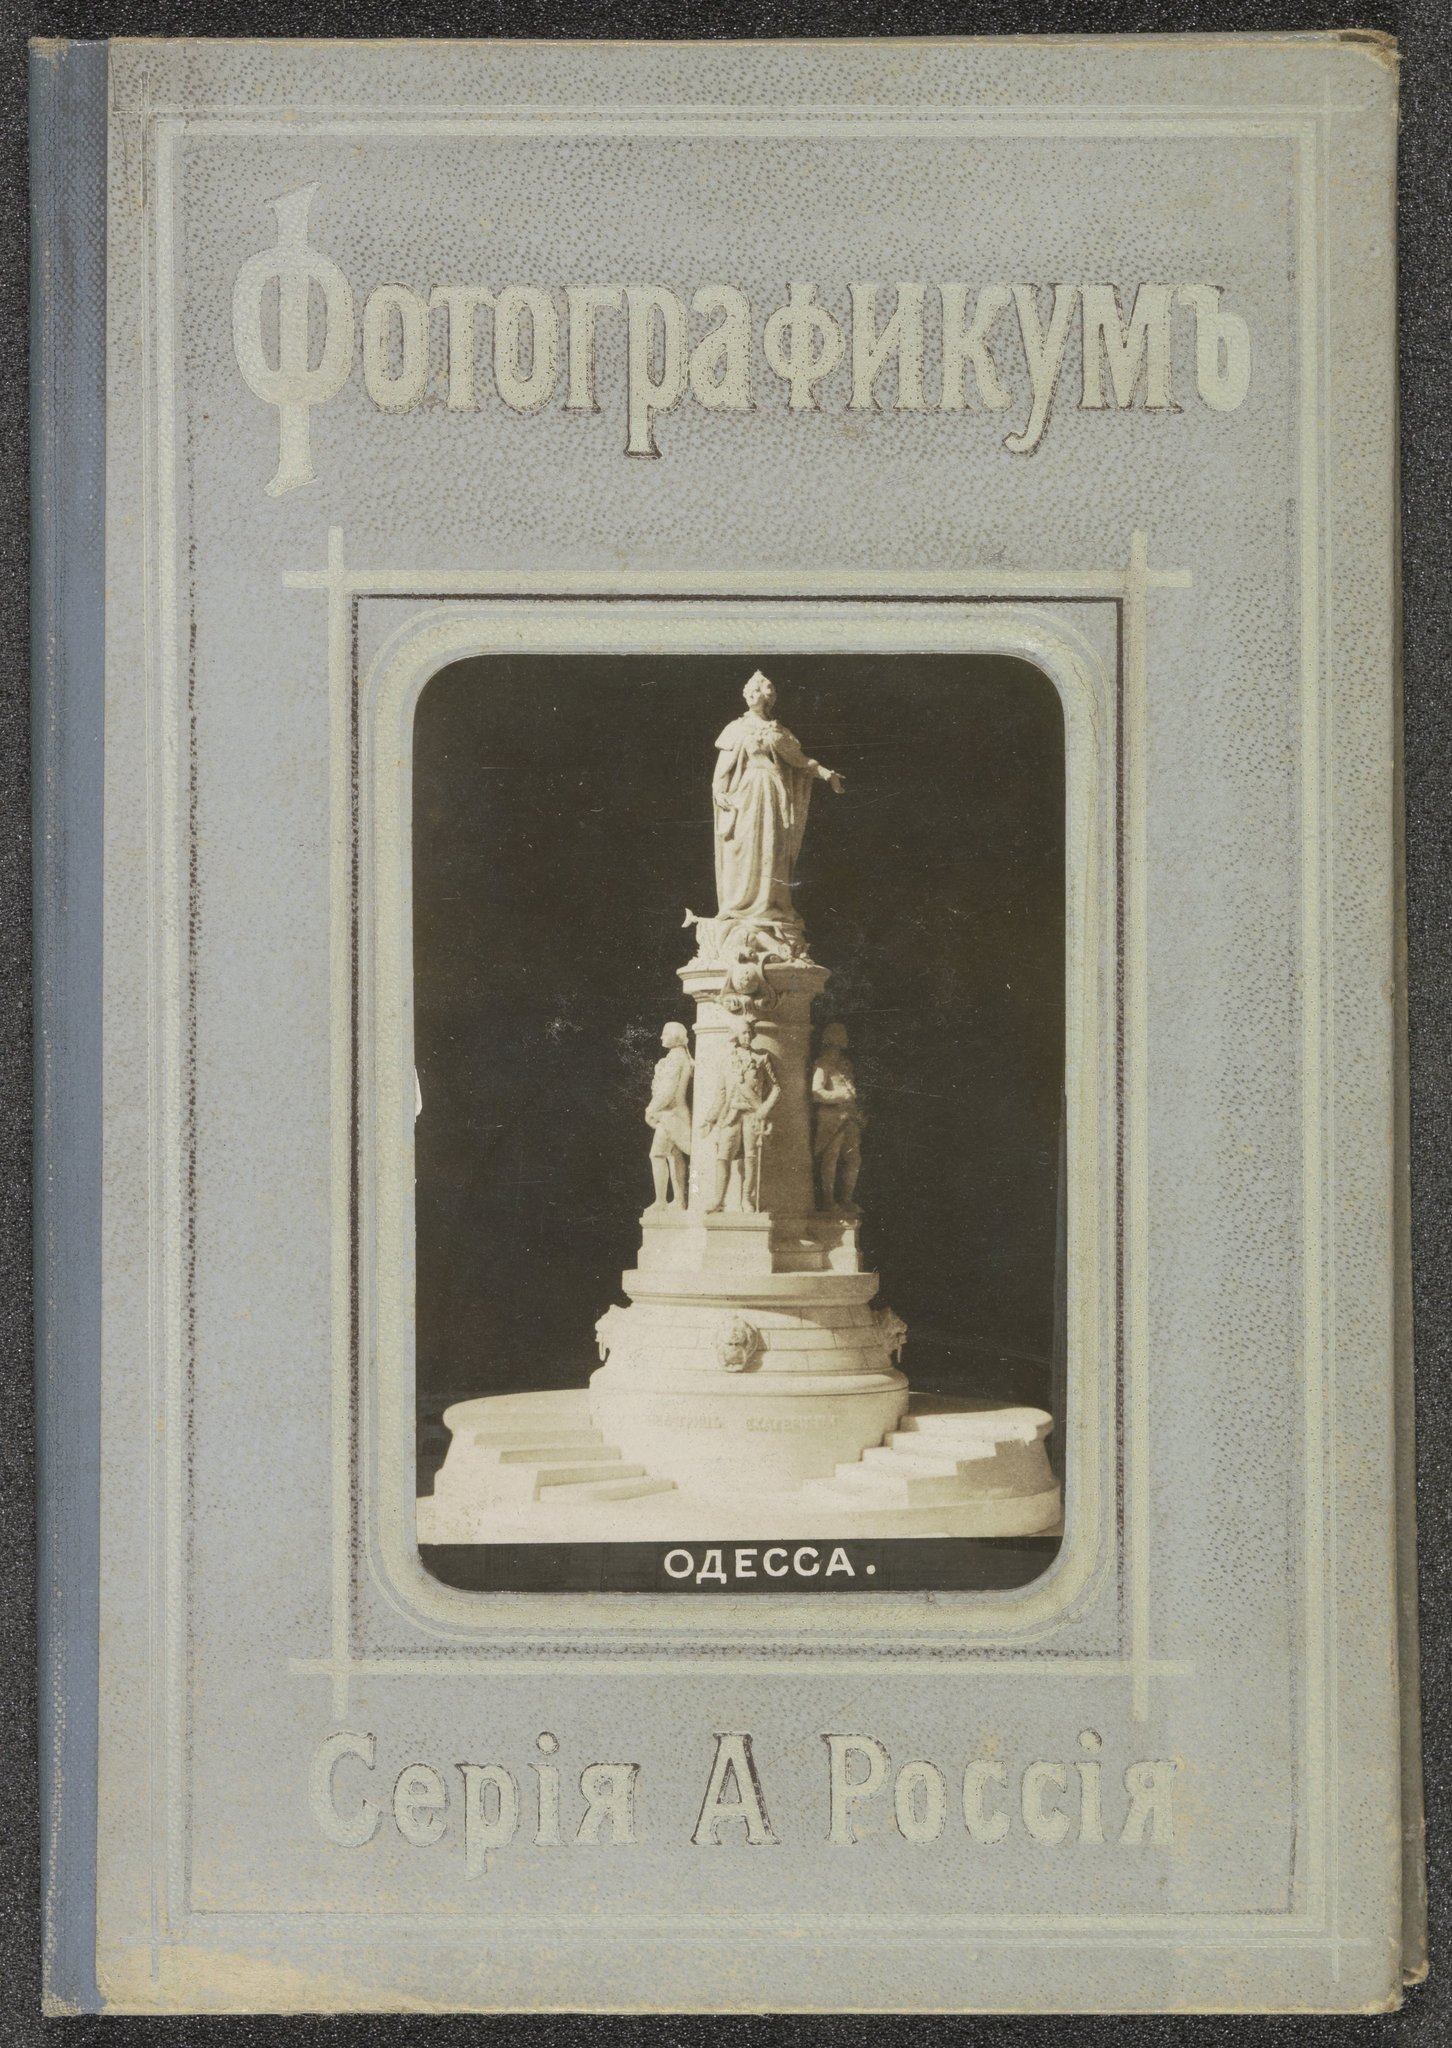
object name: photograph album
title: Fotoalbum met opnames van bezienswaardigheden in Odessa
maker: Anonymous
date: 1900-1930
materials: cardboard, linen, paper, photographic support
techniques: gelatin silver print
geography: russia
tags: travelling; tourism, prospect of city, town panorama, silhouette of city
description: Grijsblauwe verzamelmap ('fourflap') met op het voorplat een foto van (vermoedelijk) een gipsmodel van het standbeeld van Catharina de Grote in Odessa en de titel in het Russisch. Het schutblad en de stofflappen hebben een geometrisch bladmotief. De verzamelband bevat tien afdrukken van bezienswaardigheden in Odessa, zoals standbeelden, gebouwen, straten en de haven. Alle foto's zijn voorzien van titels in het Frans en in het Russisch.